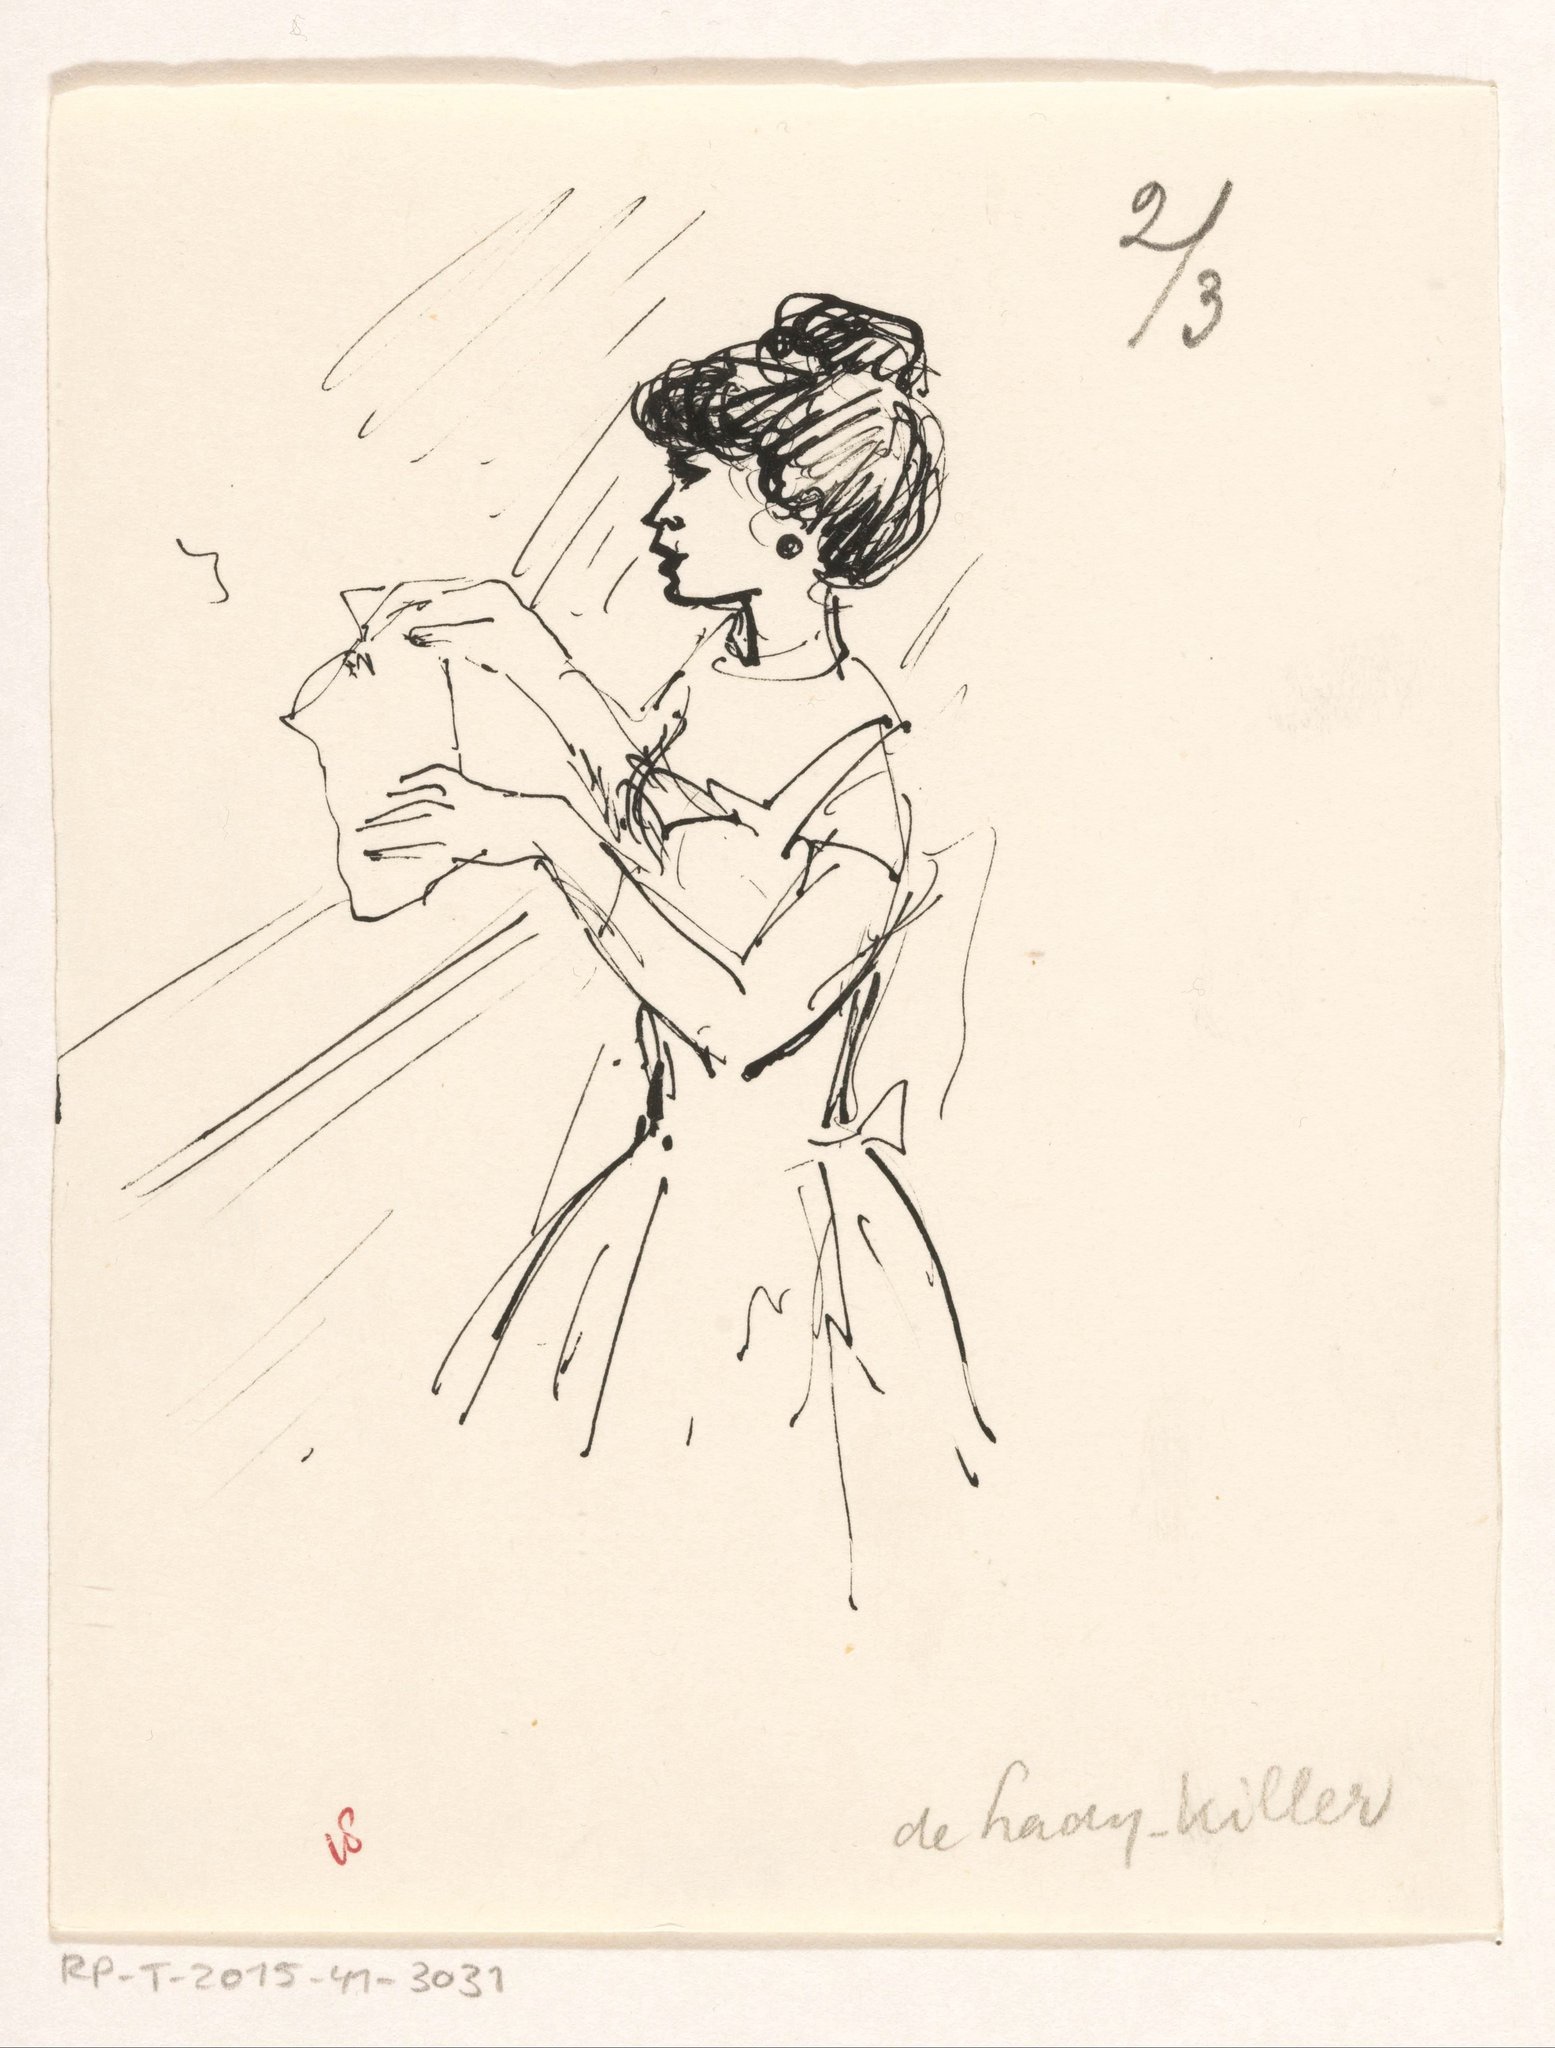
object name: drawing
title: Jonge vrouw in avondjurk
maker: Anonymous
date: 1930-1970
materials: ink, paper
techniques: pen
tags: standing figure (+ young female (human being)), dress, gown: evening dress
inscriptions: annotation: ‘de Lady-killer’, collector's mark: Lugt 2228a, :, number: ‘18’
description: De vrouw heeft opgestoken haar en oorbellen in haar oren. In haar handen heeft ze een voorwerp, mogelijk een vel papier of brief.